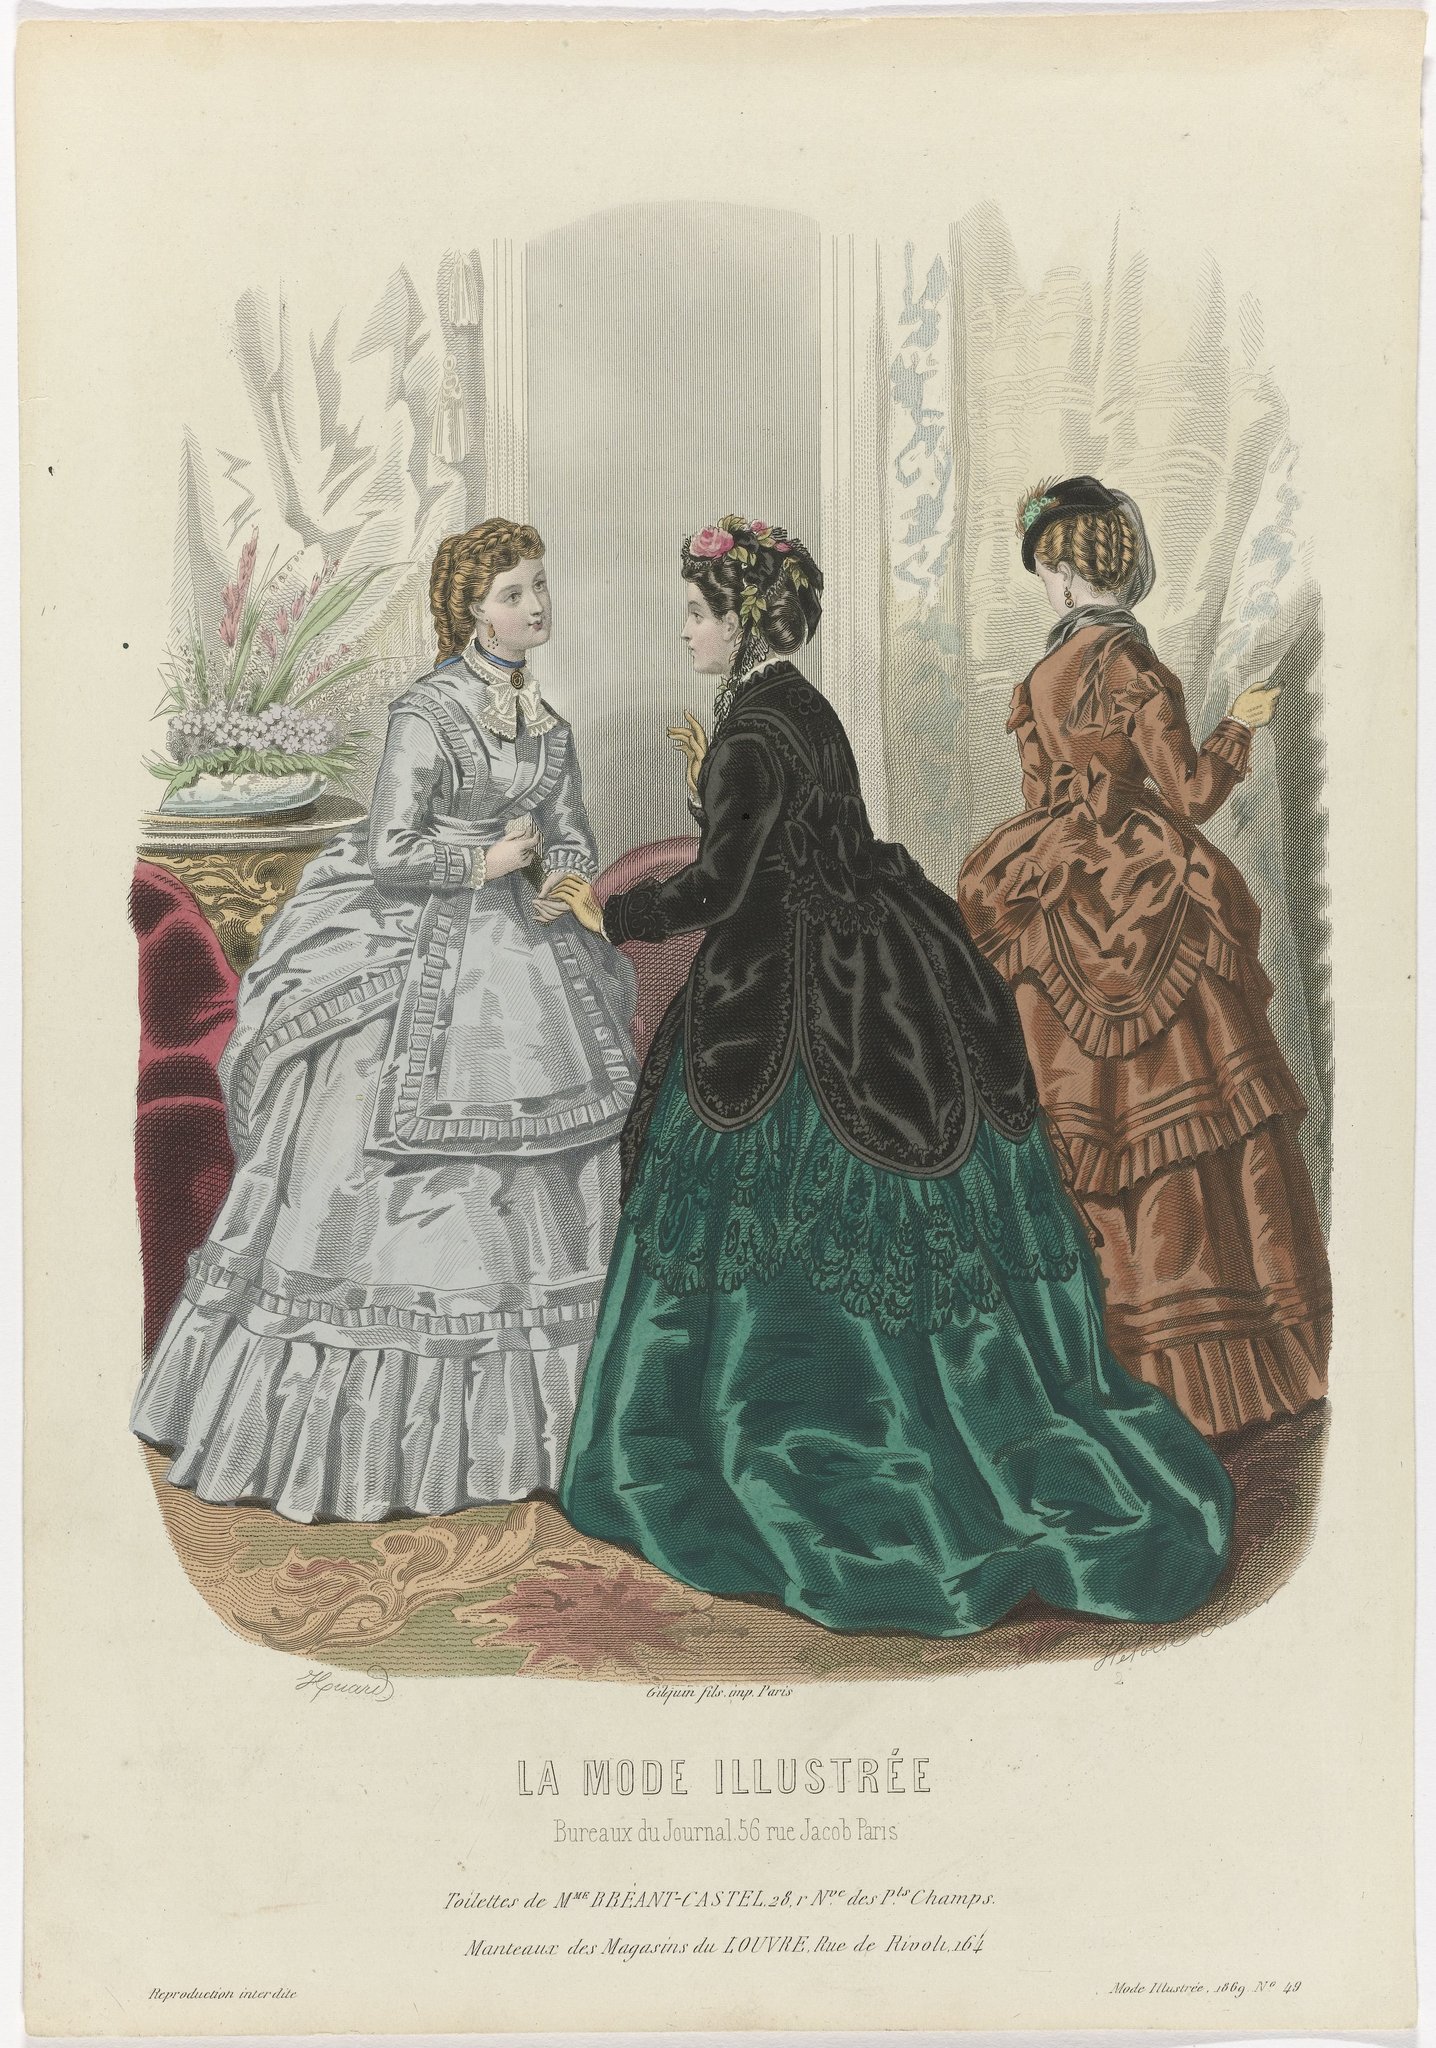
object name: fashion print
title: La Mode Illustrée, 1869, No. 49: Toilettes de Mme Breant-Castel (...)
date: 1869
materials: paper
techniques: engraving, hand coloring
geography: paris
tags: ear-rings (+ women's clothes), pendant, trinket, 'breloque' (+ women's clothes), coat (+ women's clothes), head-gear (+ women's clothes), fashion plates, gloves, mittens, etc. (+ women's clothes), neck-gear ~ clothing (+ women's clothes)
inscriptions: address: ‘Bureaux du Journal, 56, Rue Jacob. Paris’, caption: ‘Toilettes de Mme Breant-Castel. 28. r N.ve des P.ts Champs. Manteaux des Magasins du Louvre. Rue de Rivoli. 164’, title: ‘La Mode Illustrée’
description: Drie vrouwen, van wie één op de rug gezien, in een interieur. Volgens het onderschrift: ensembles van Breant-Castel. Mantels van 'Magasins du Louvre'. Prent uit het modetijdschrift La Mode Illustrée (1860-1937).